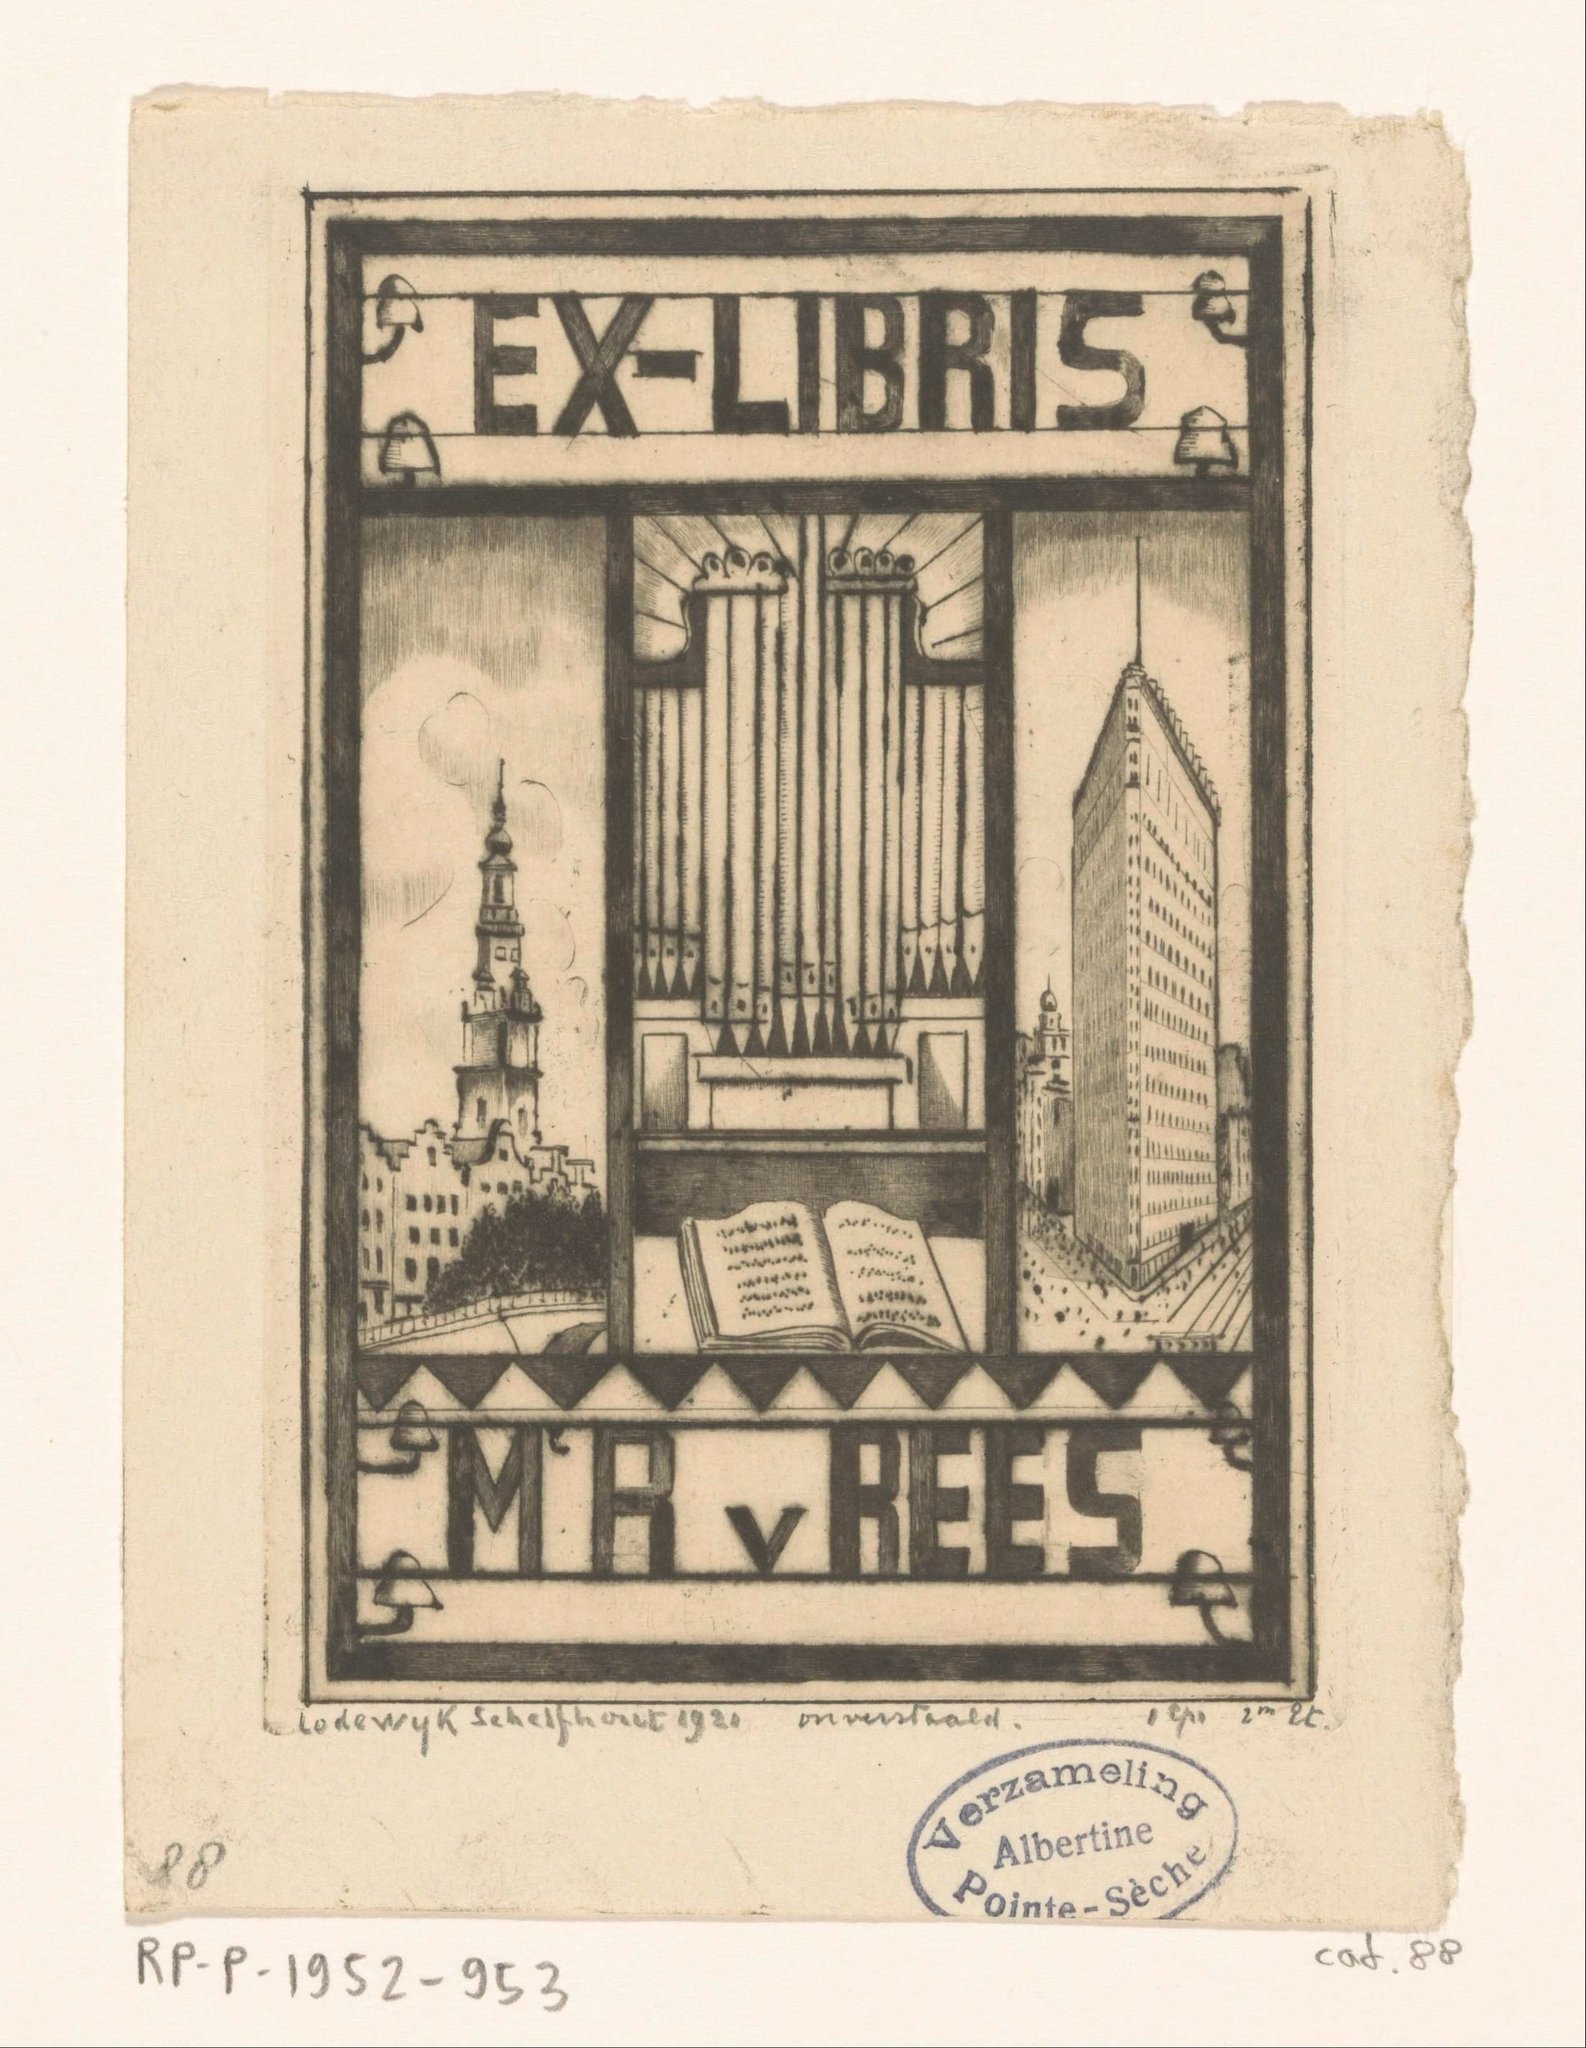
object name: bookplate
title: Ex libris van M.A. van Rees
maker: lodewijk schelfhout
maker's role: draughtsman, print maker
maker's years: 1881-1943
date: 1921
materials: paper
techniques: drypoint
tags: skyscraper, church organ, parts of church exterior and annexes: tower, netherlands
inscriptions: collector's mark: Lugt 5i, collector's mark: Lugt 2760, collector's mark: Lugt 2228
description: In het midden een kerkorgel en een opengeslagen boek. Links de toren van een kerk achter huizen met trapgevels, rechts het Flatiron Building in New York.